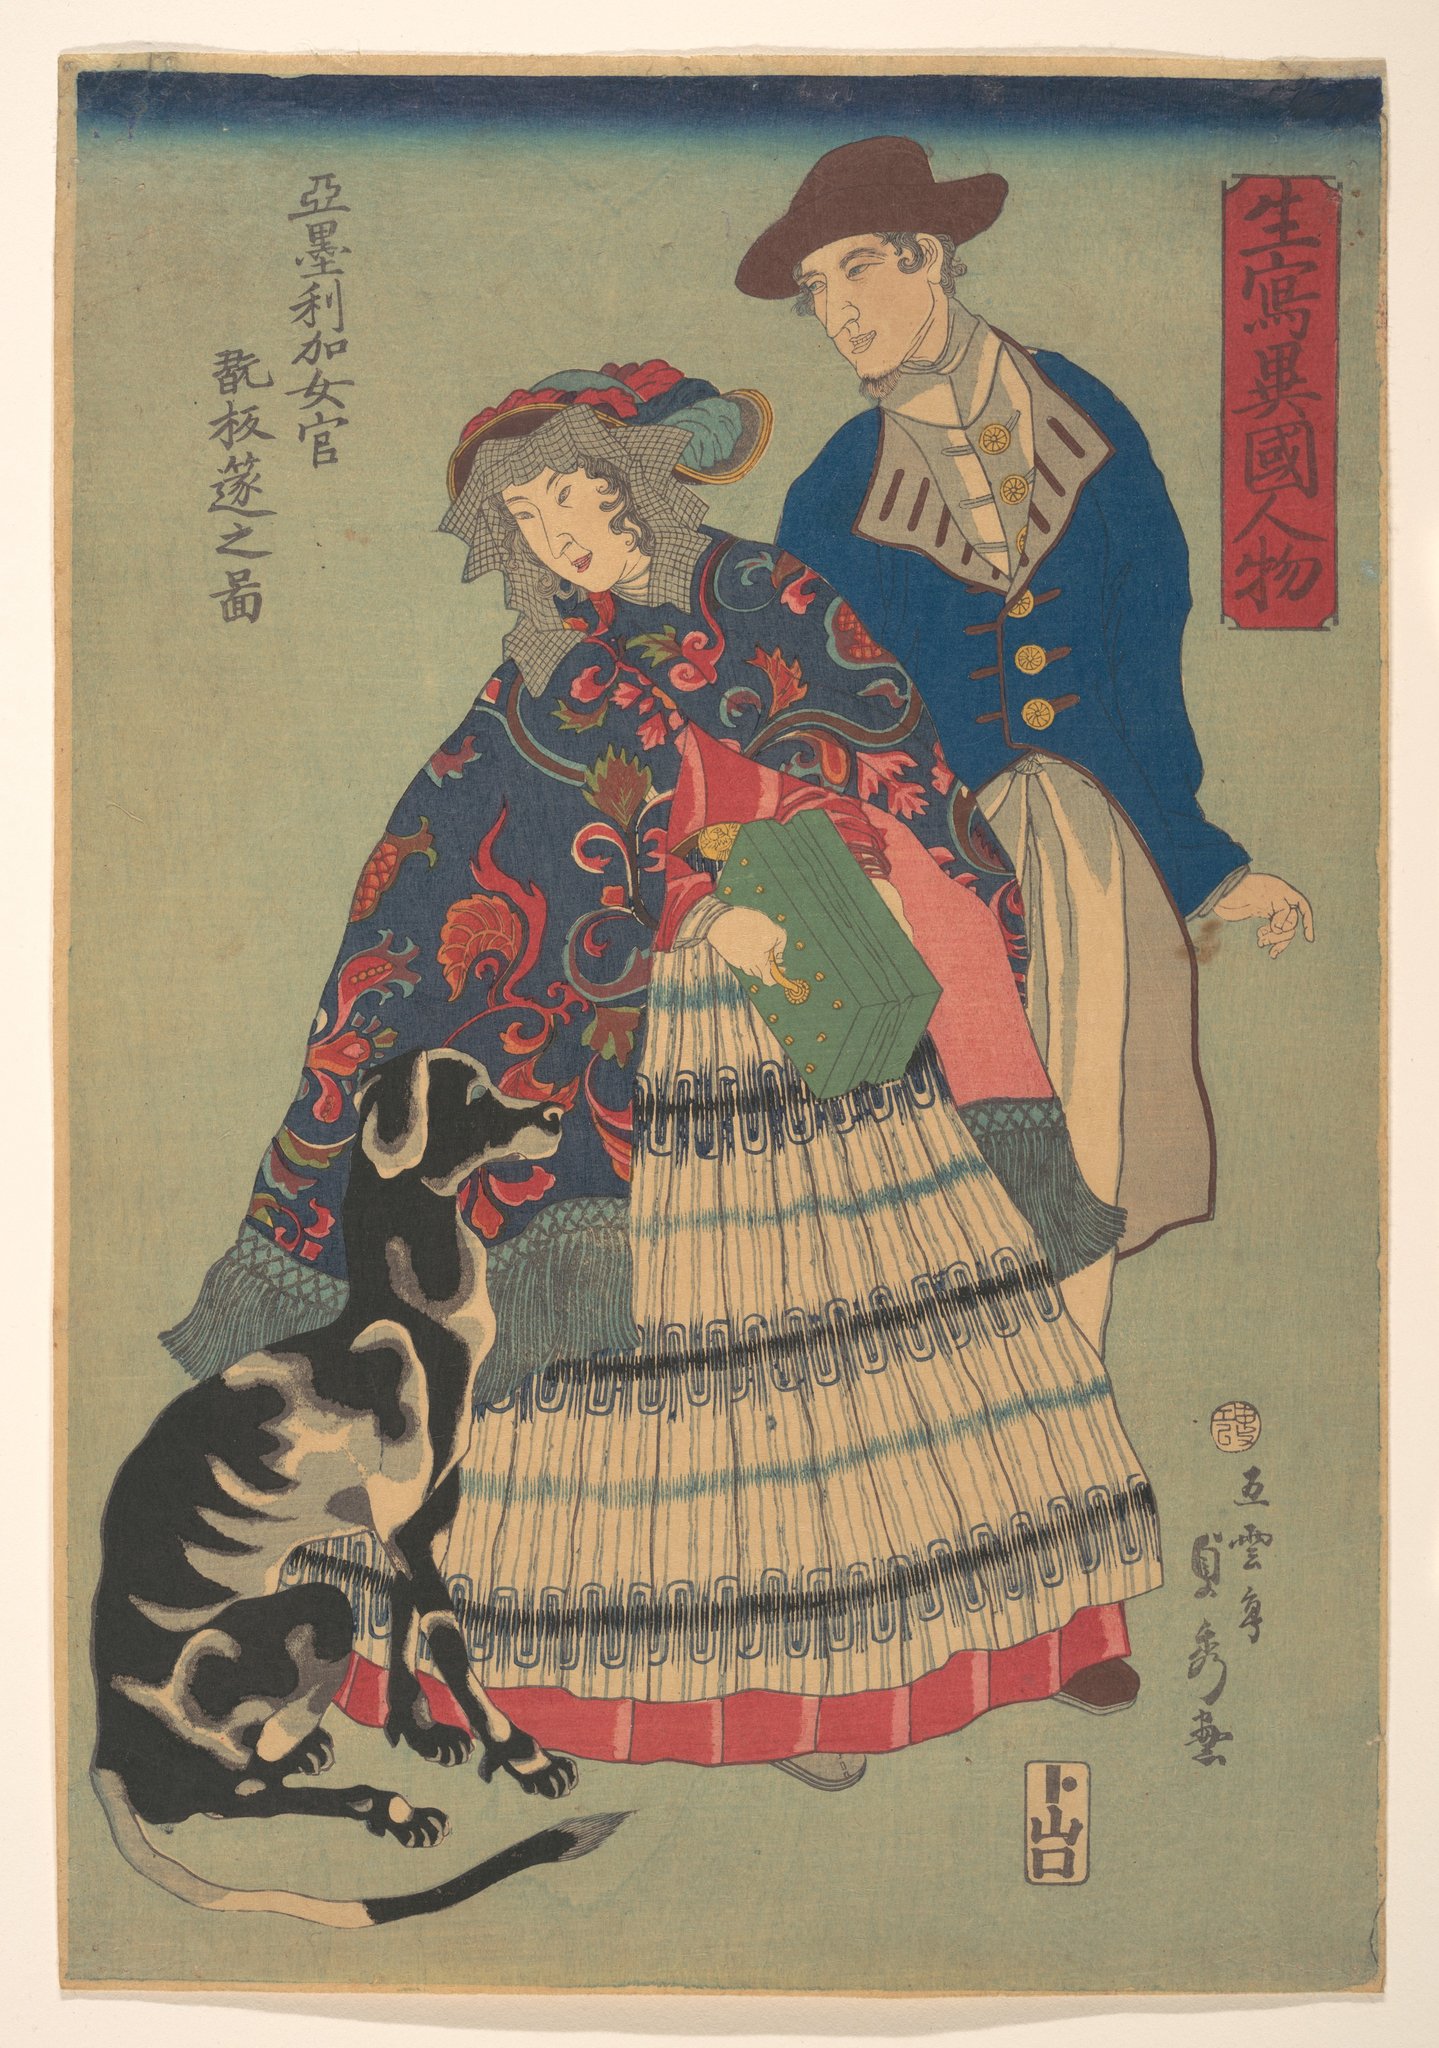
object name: print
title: American Woman Playing a Concertina, from the series Life Drawings of People from Foreign Nations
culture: japanese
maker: utagawa (gountei) sadahide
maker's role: artist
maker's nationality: japanese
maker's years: 1807-1873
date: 1860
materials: ink, paper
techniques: woodblock print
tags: musical instruments,men,women,dogs